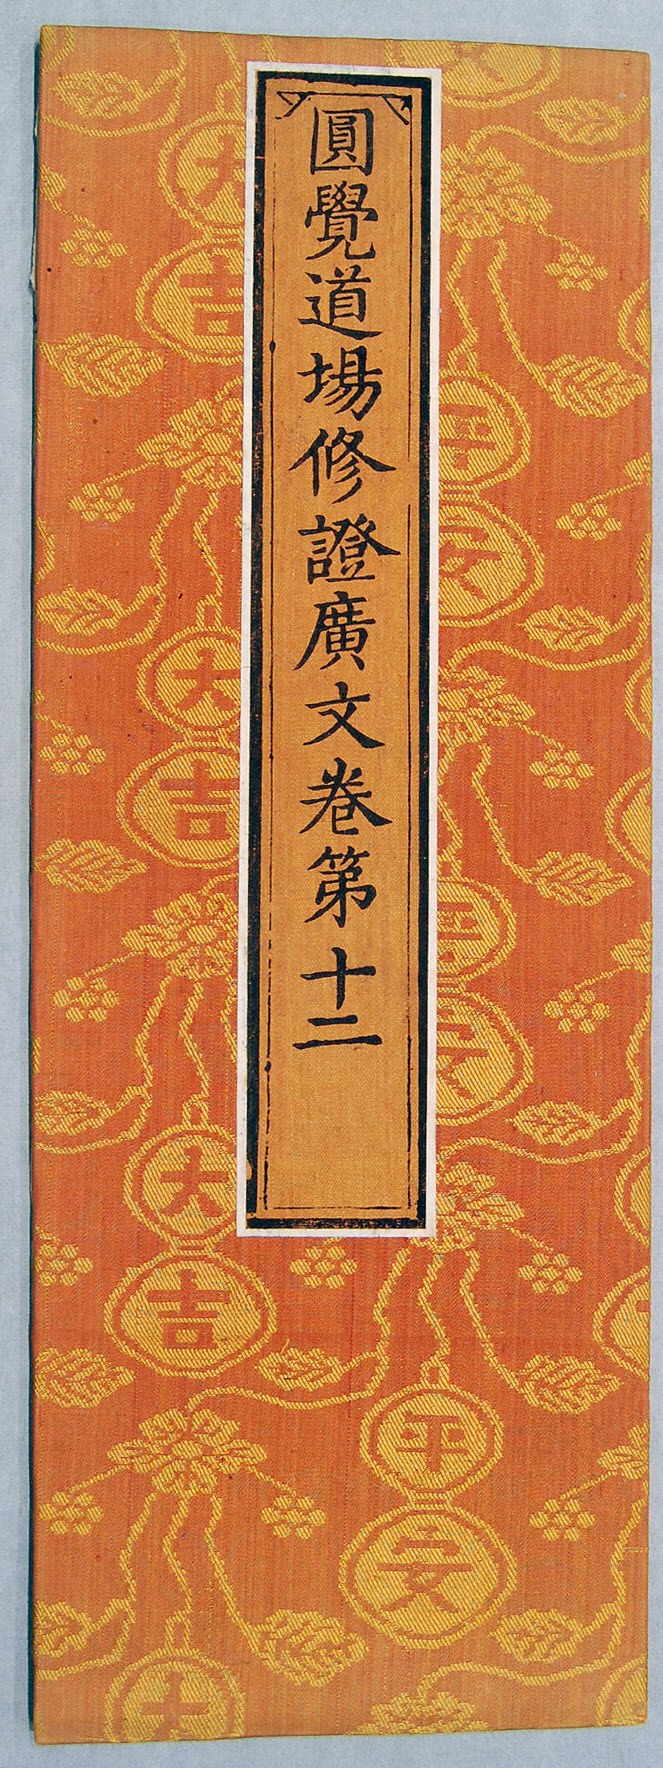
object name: sutra cover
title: Sutra Cover with Pattern of Double-Gourd Shapes Containing Auspicious Chinese Characters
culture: chinese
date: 1501-1600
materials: silk